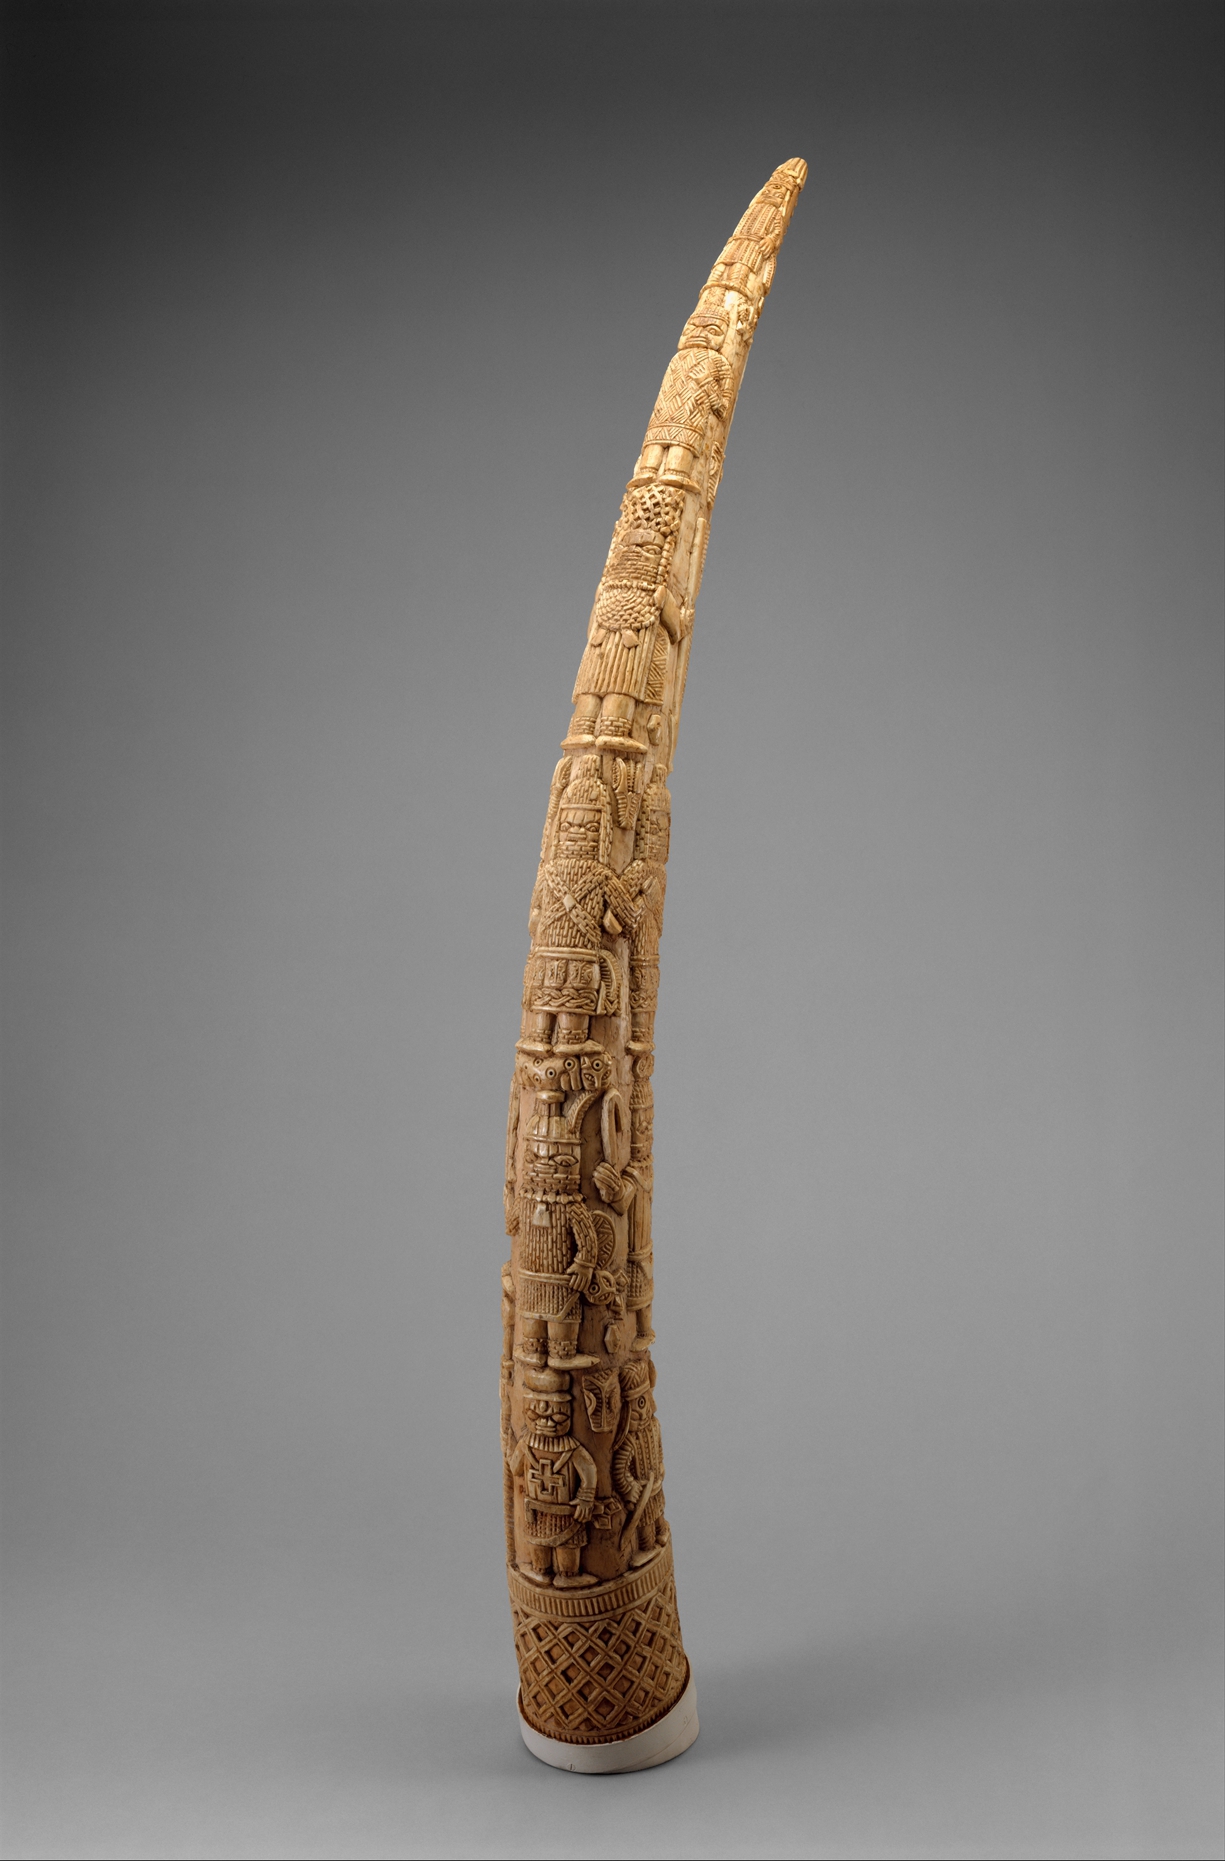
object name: altar tusk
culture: edo period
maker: ìgbèsànmwà (ivory- and wood- carving guild) artists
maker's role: artist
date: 1888-1897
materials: ivory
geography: nigeria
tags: men